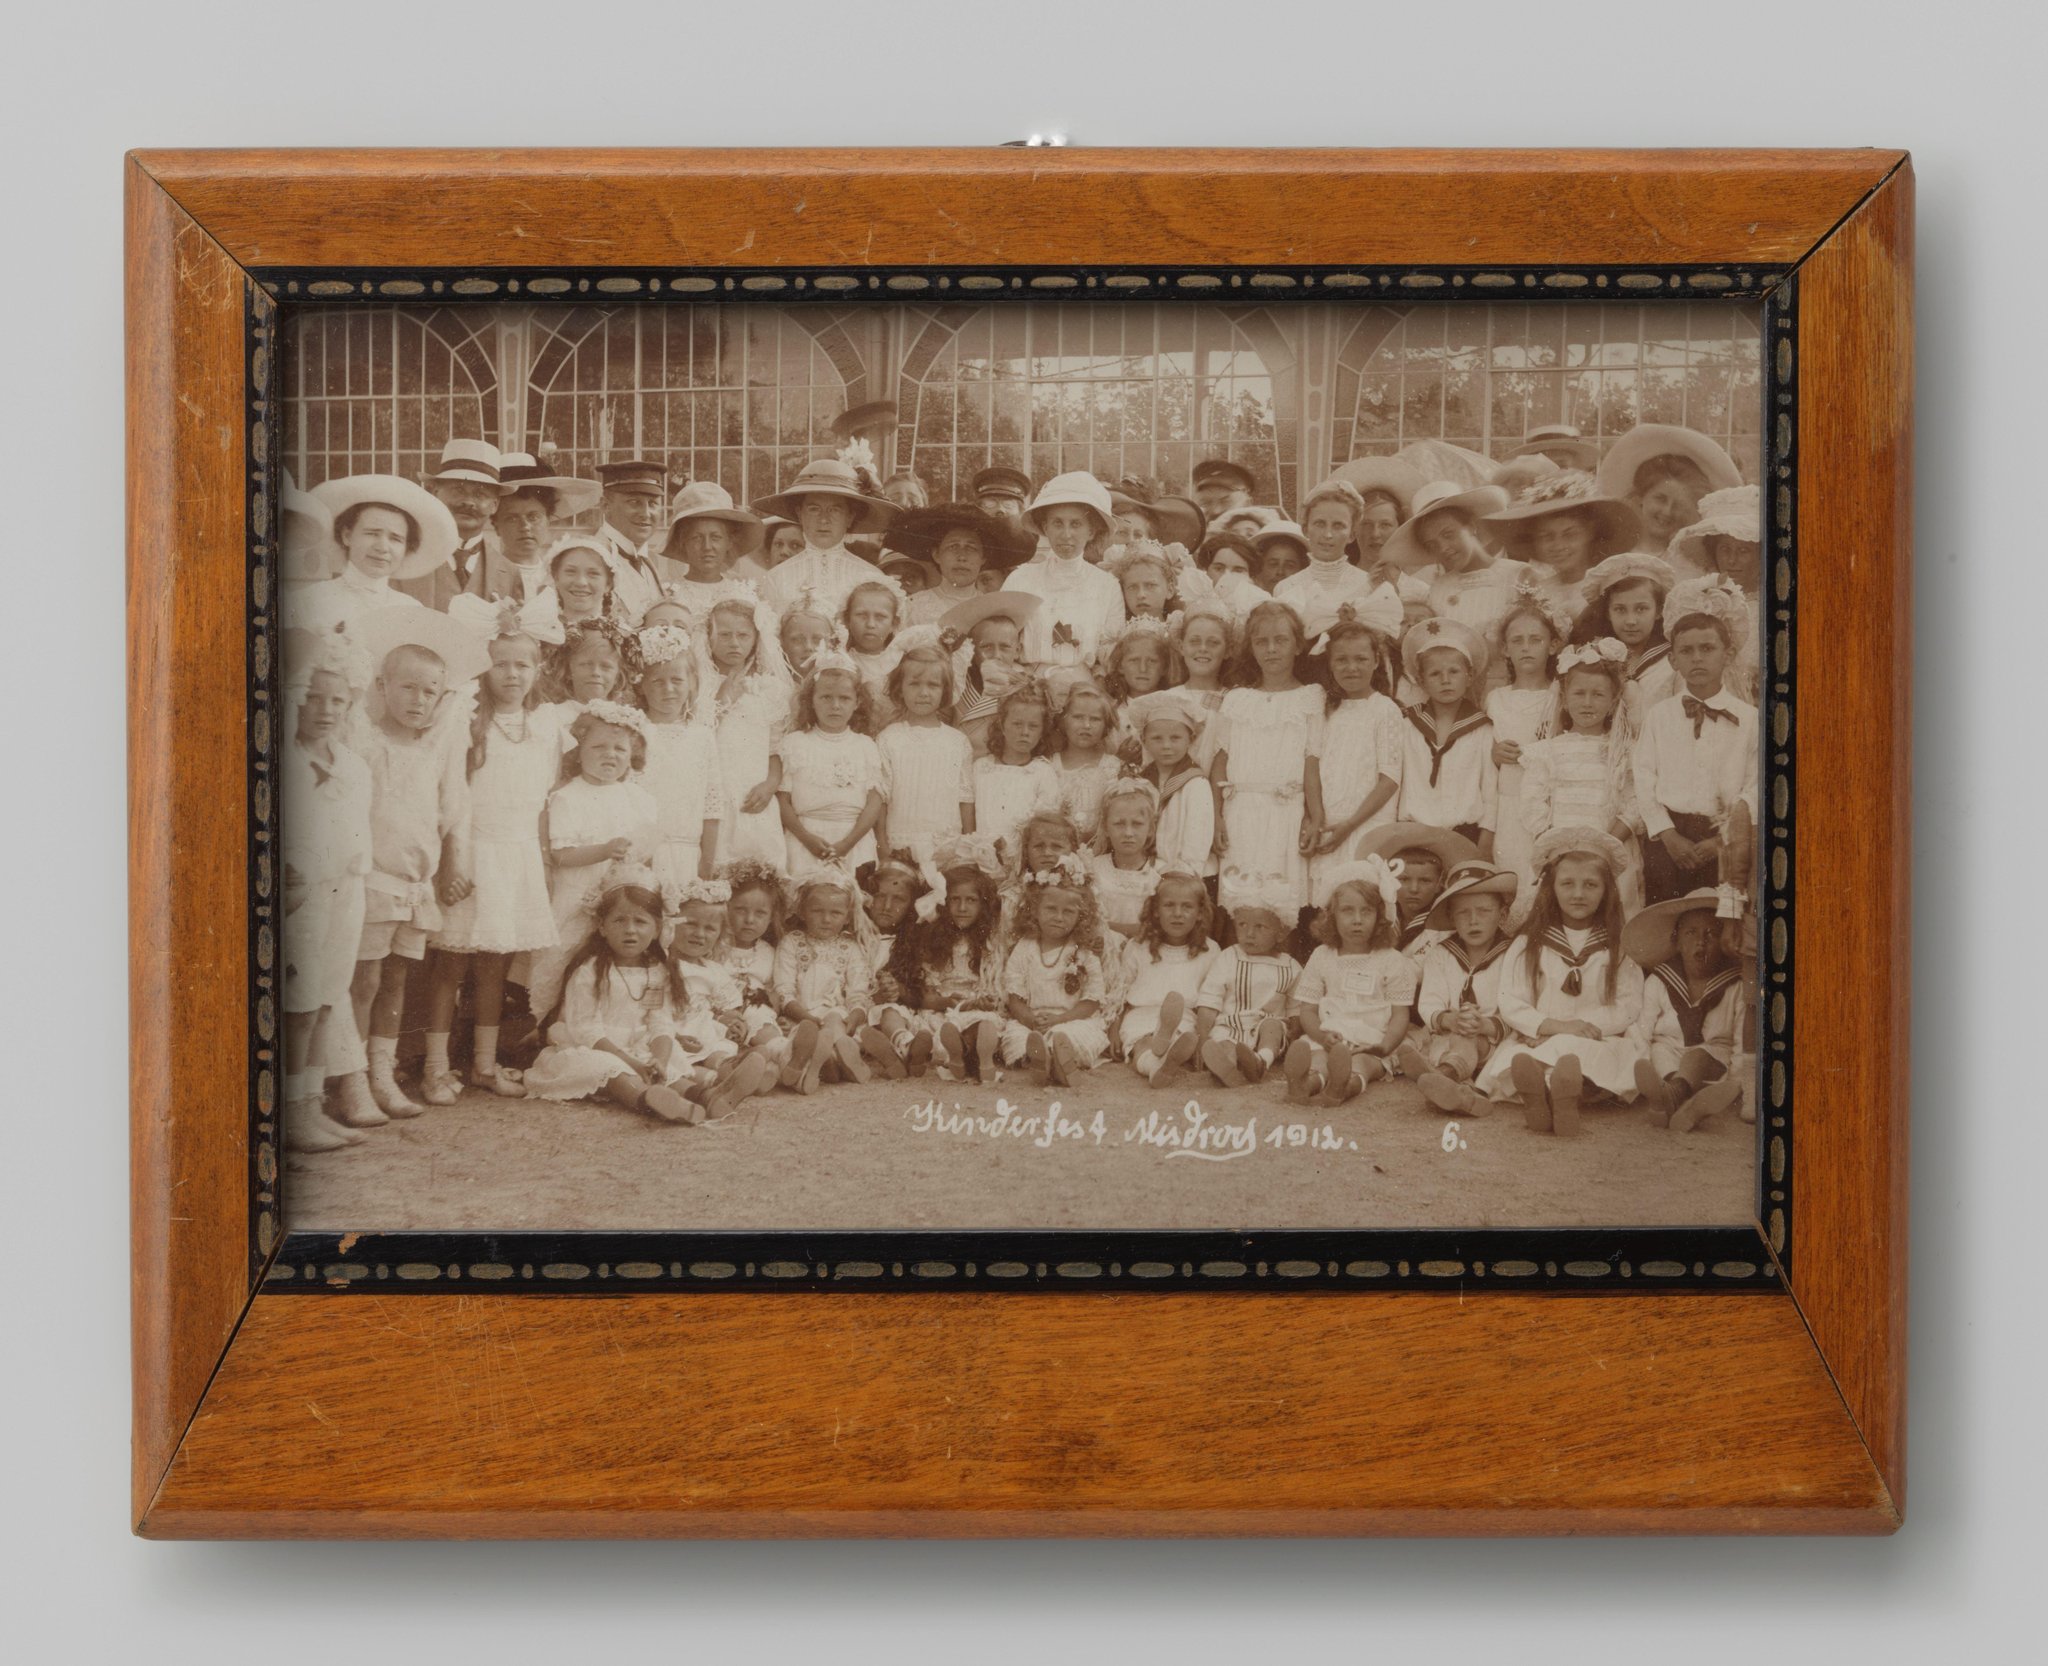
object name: frame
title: Groepsportret van onbekende mannen, vrouwen en kinderen tijdens een kinderfeest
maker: Anonymous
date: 1912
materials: paper, cardboard, glass, metal, wood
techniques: collodion silver print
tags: anonymous historical persons portrayed in a group, in a group-portrait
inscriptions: number: ‘6’, inscription: ‘Kinderfest [...] 1912’